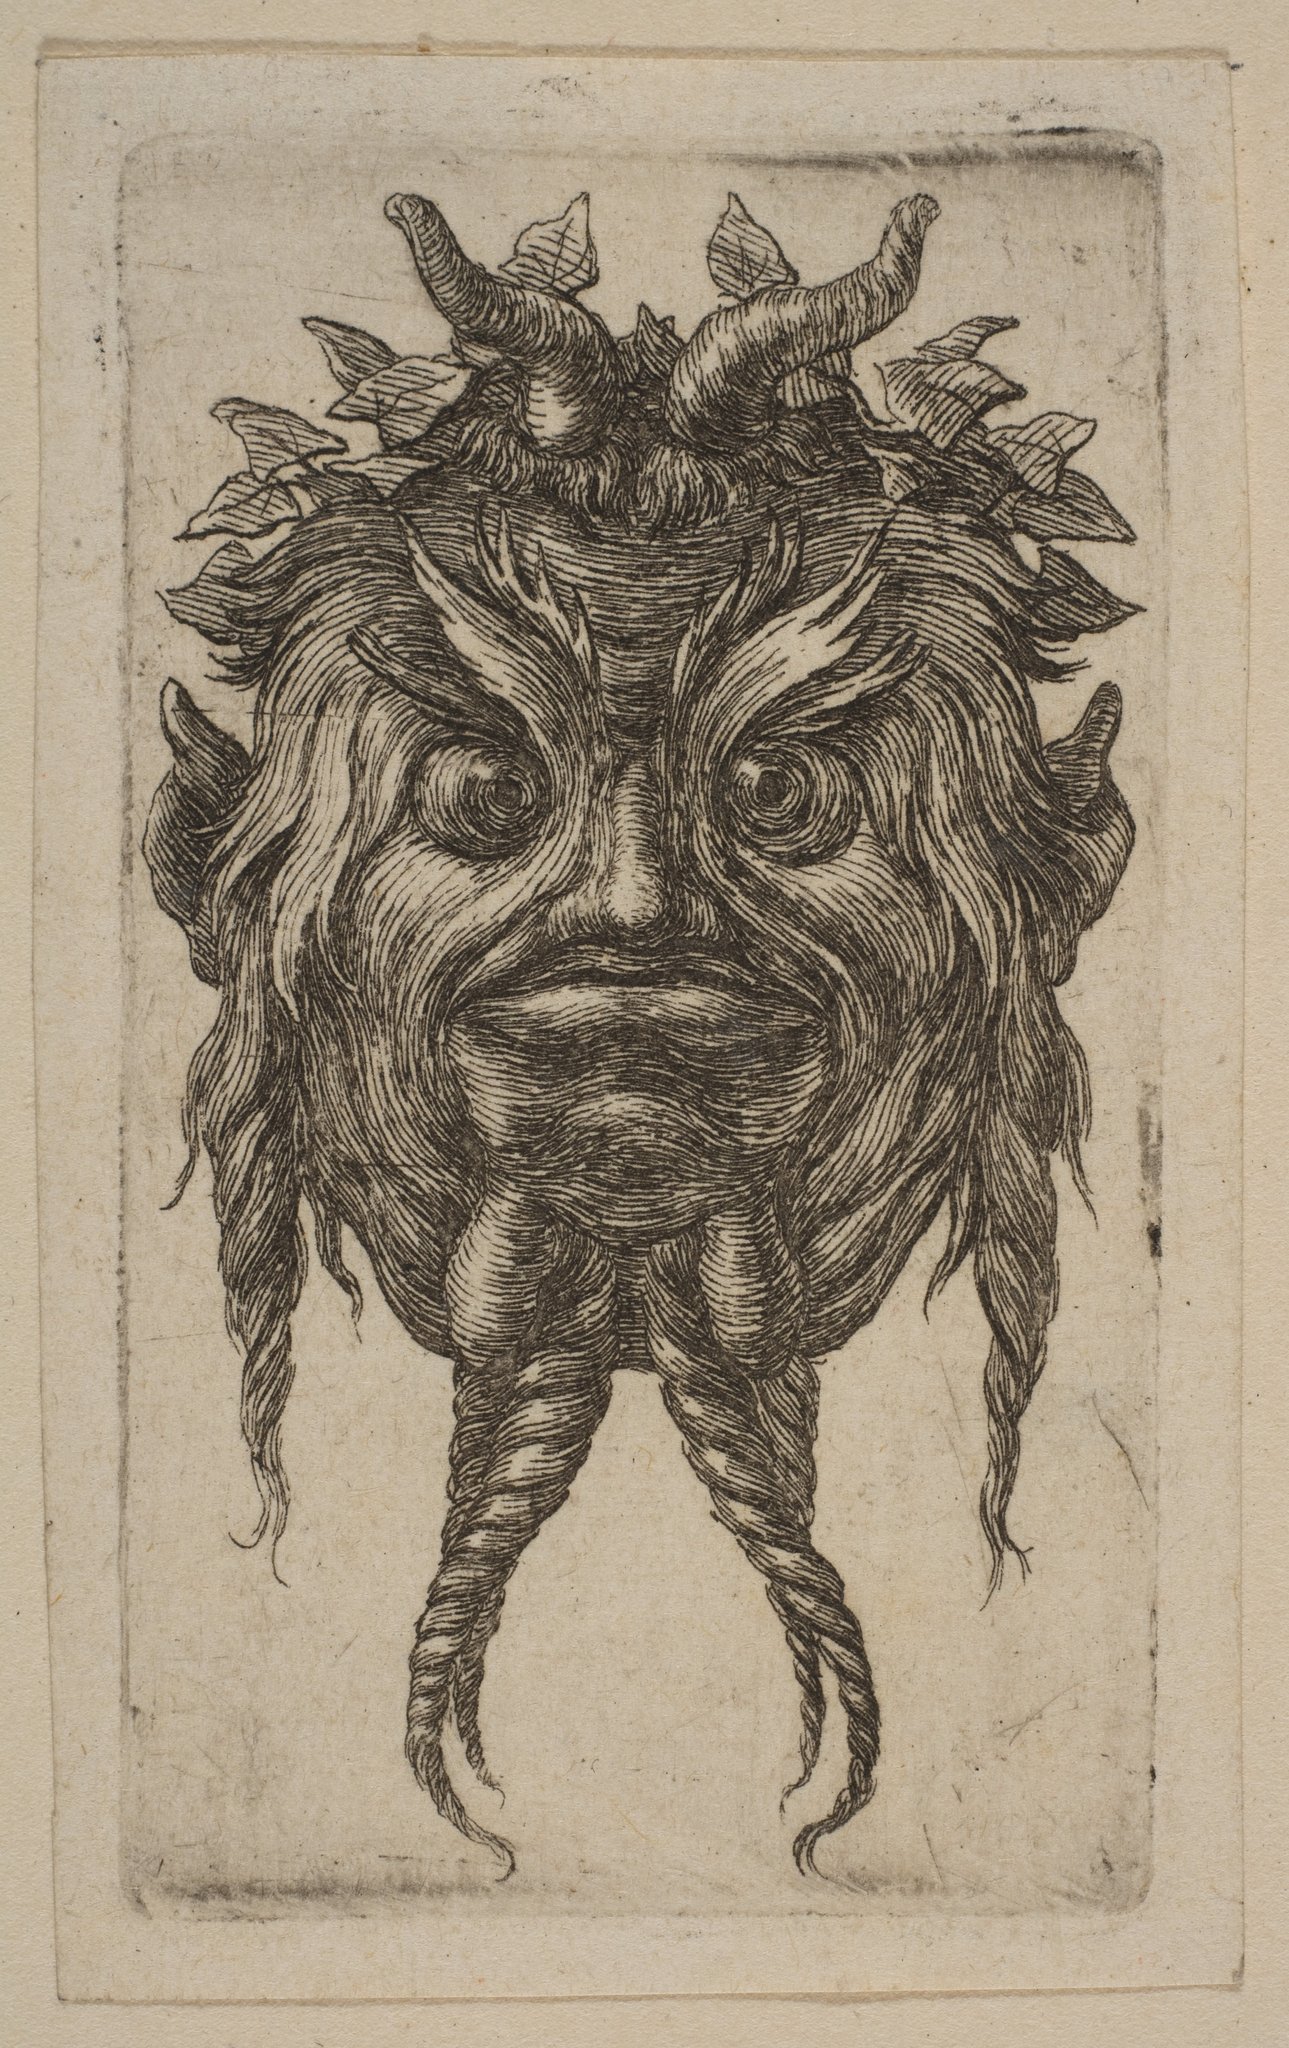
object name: print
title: Mask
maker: stefano della bella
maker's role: artist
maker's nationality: italian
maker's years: 1610-1664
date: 1610-1664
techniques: etching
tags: masks